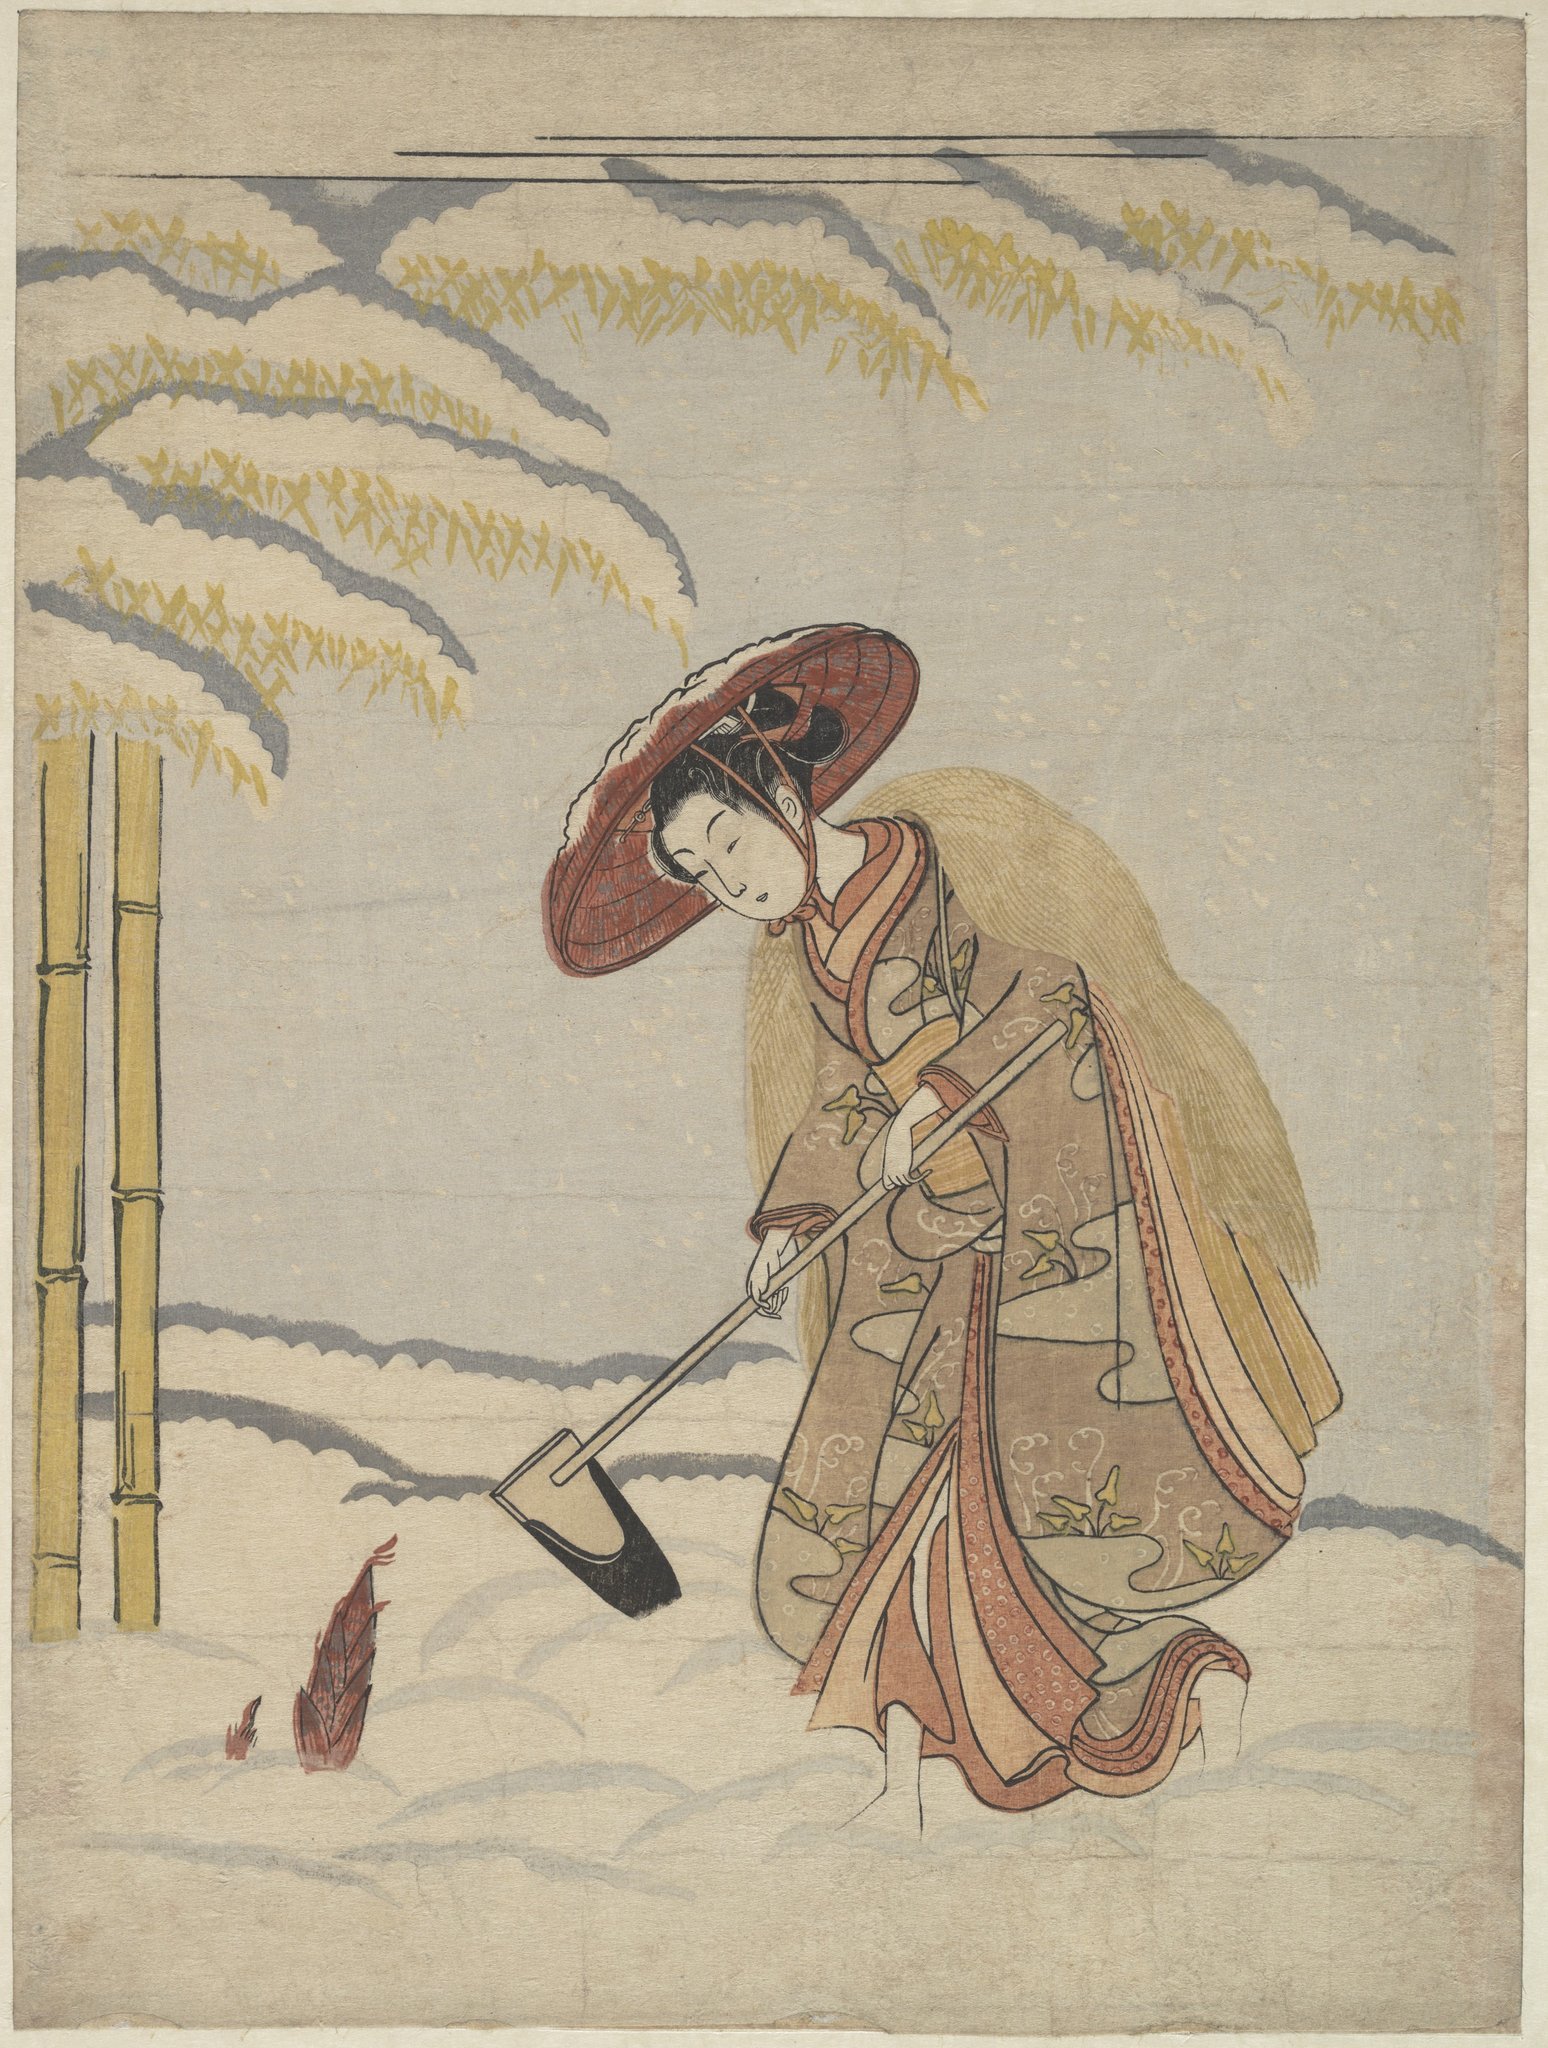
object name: print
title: Woman Digging Bamboo Shoots in the Snow, or Parody of Meng Zong (Mōsō), from Twenty-Four Paragons of Filial Piety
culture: japanese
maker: suzuki harunobu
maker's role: artist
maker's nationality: japanese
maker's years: 1725-1770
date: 1765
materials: ink, paper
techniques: woodblock print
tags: women,bamboo,snow,working